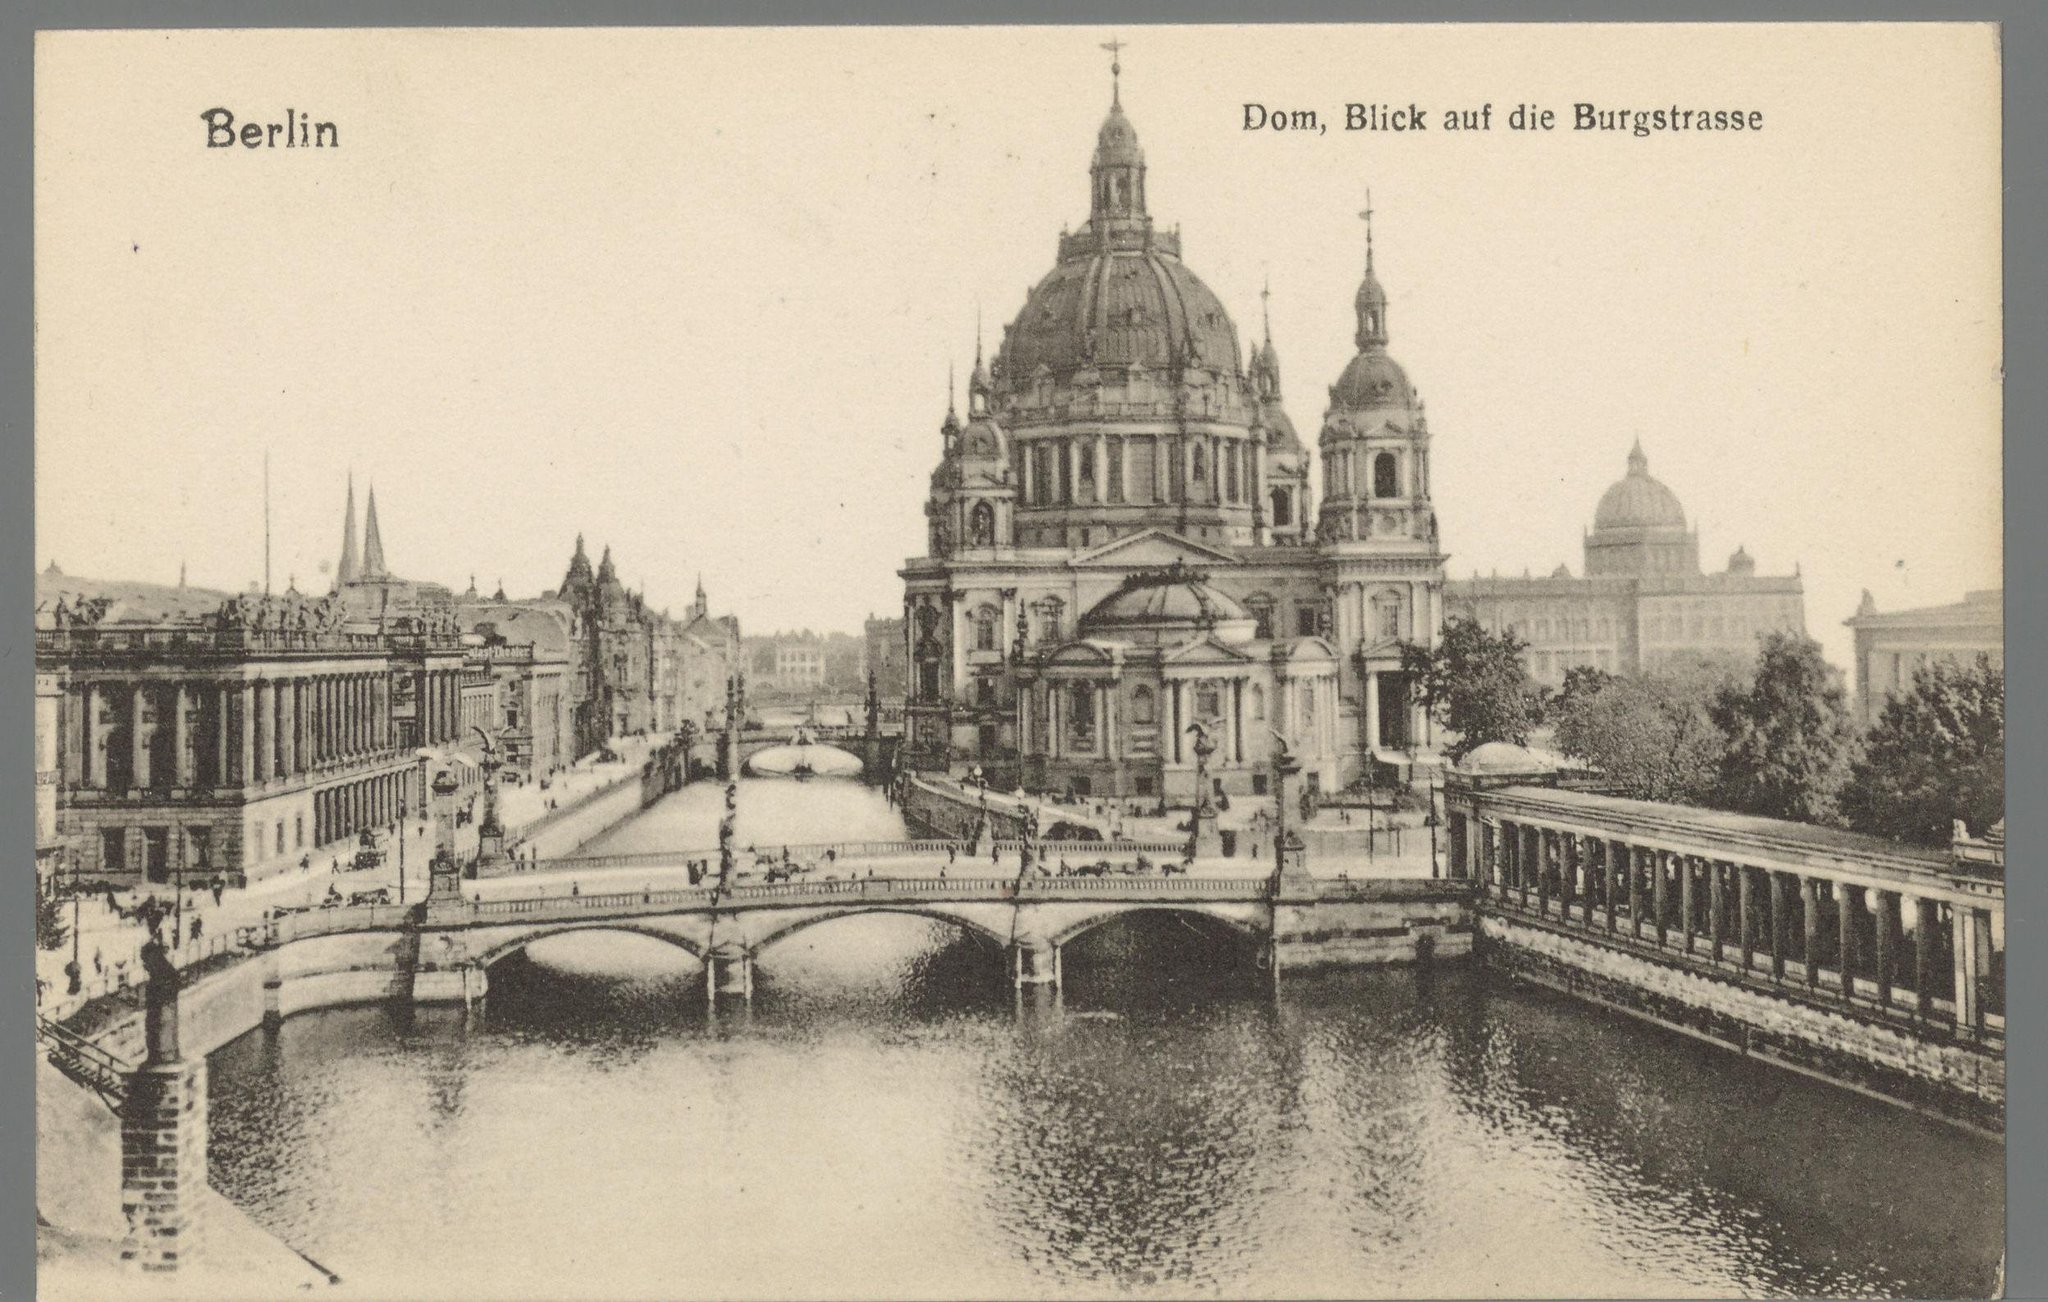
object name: ansichtkaart, prentbriefkaart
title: Berlin. Dom, Blick auf die Burgstrasse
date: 1905-1930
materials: cardboard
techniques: photograph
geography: berlin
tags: church (exterior), canals, waters (in city), bridge in city across river, canal, etc., street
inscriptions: stamp: ‘5’, monogram: ‘P.F.B.’